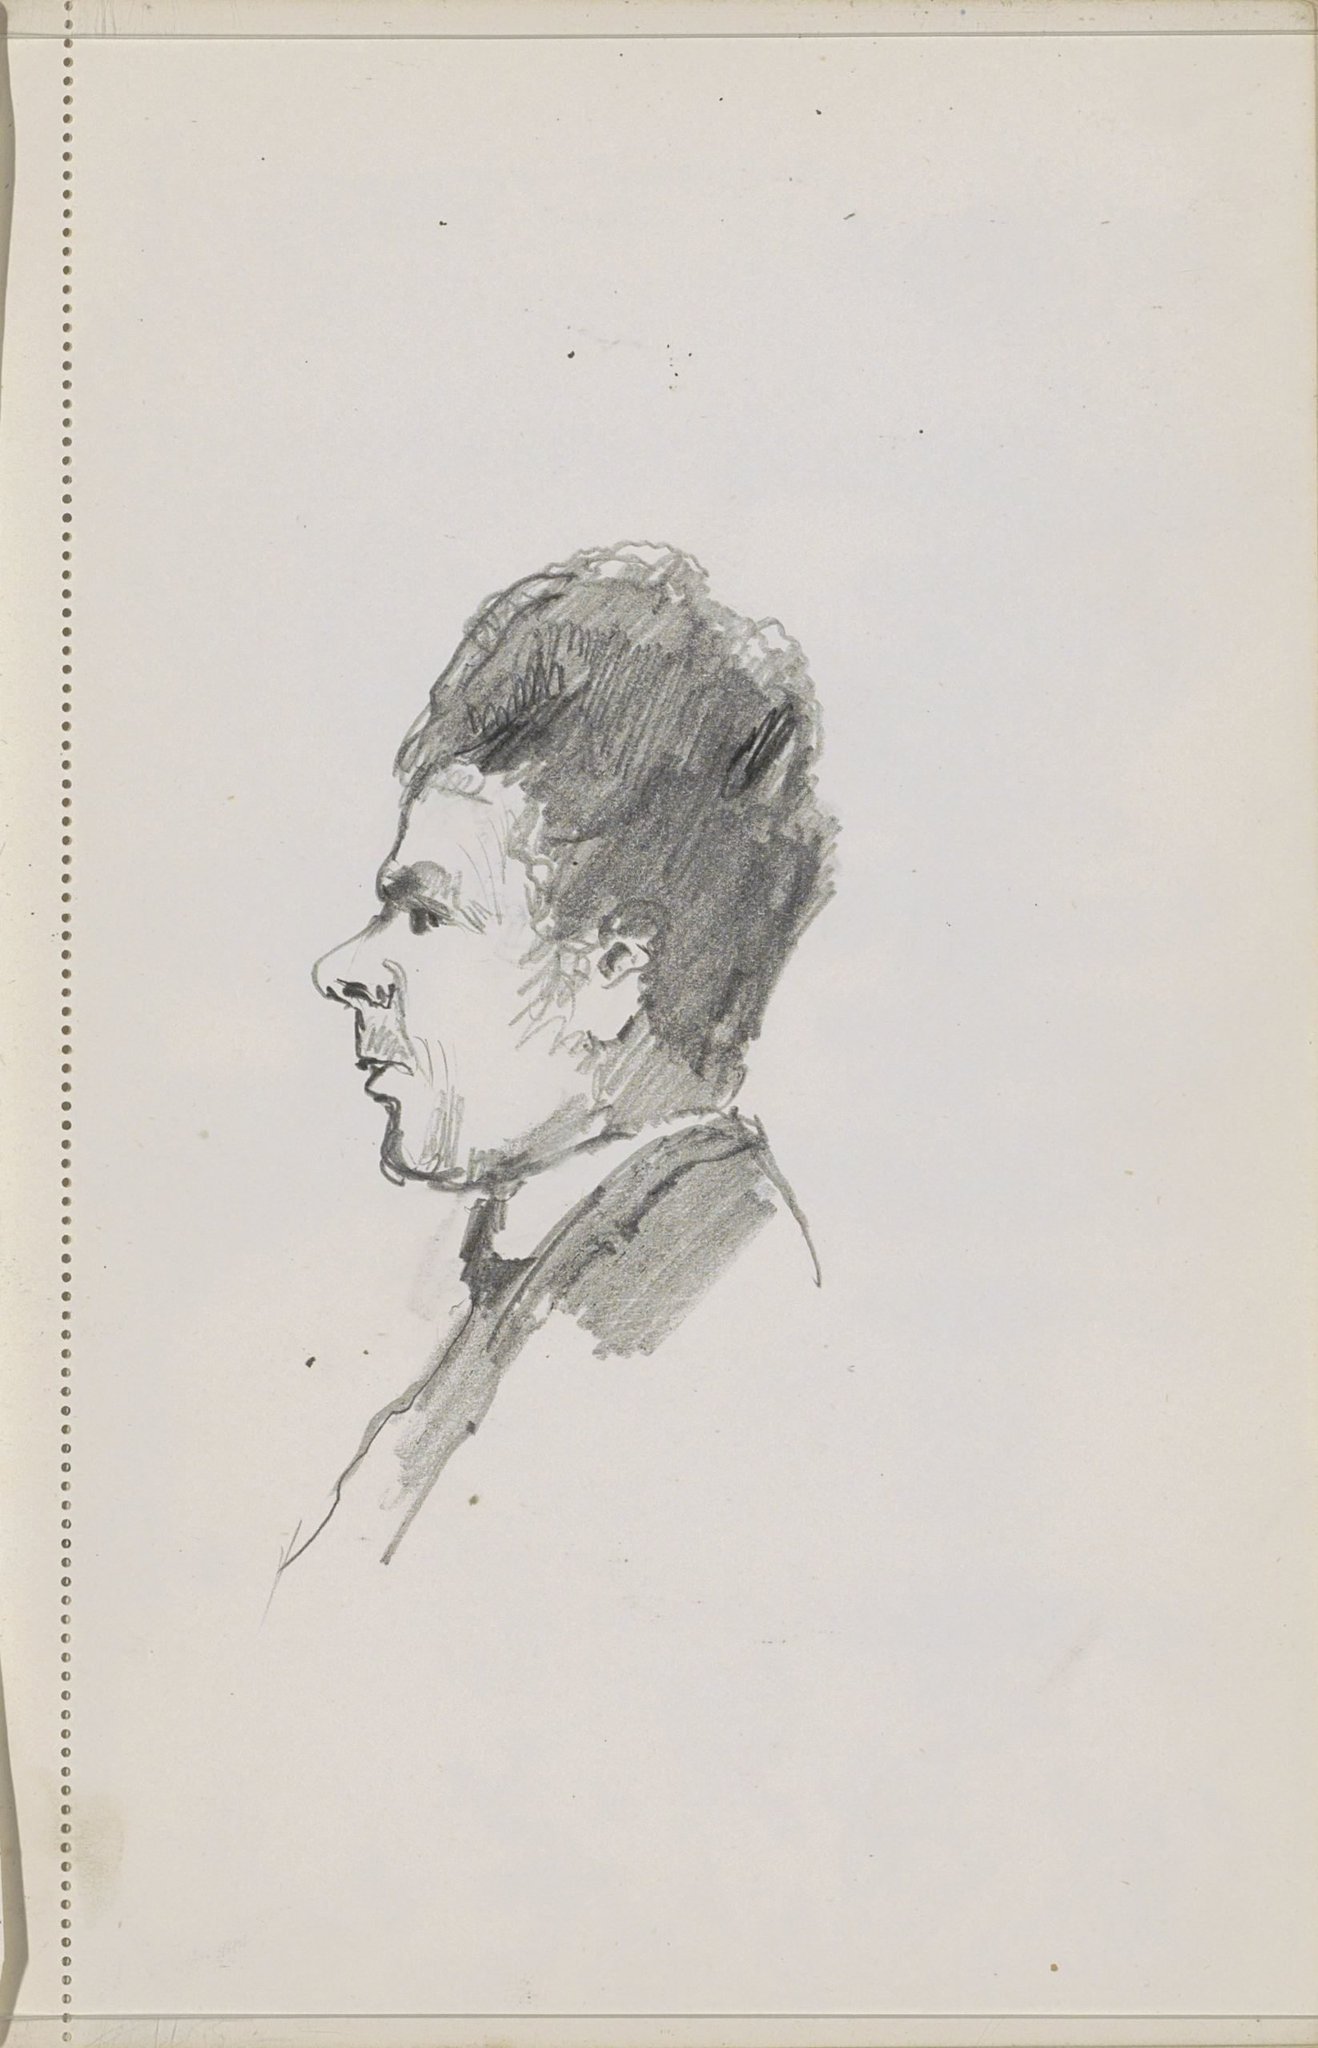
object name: sketchbook leaf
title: Portret van een man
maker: cornelis vreedenburgh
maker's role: draughtsman, print maker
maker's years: 1880-1946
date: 1890-1946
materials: paper, pencil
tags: adult man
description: Blad 8 recto uit een schetsboek met 53 bladen.